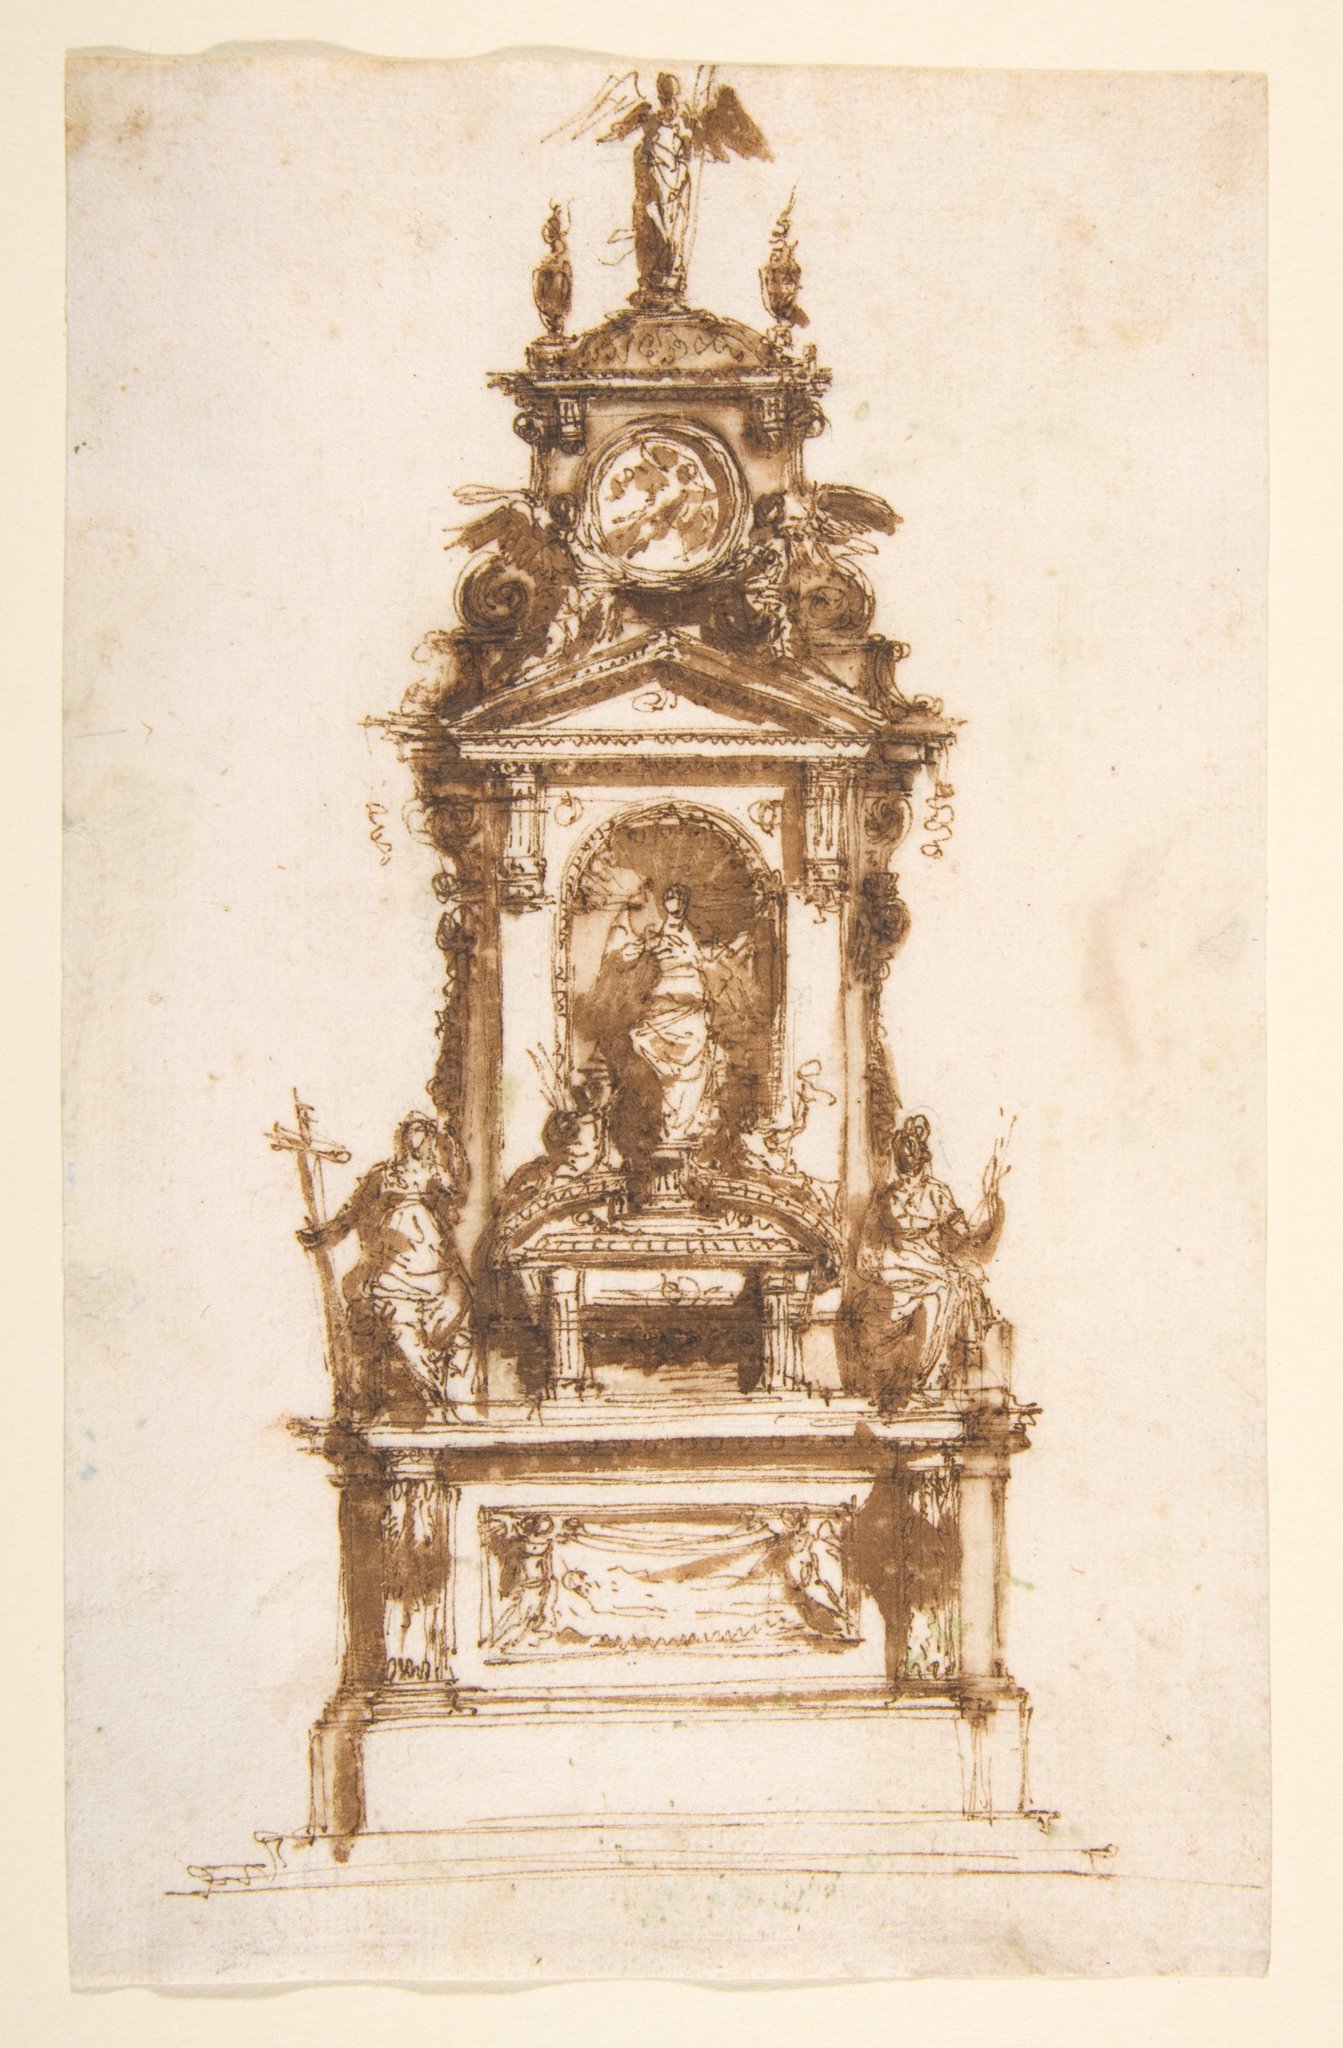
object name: drawing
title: Design for an Altar Erected for the Holy Week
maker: mauro antonio tesi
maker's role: artist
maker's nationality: italian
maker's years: 1730-1766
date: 1750-1766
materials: ink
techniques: brush, pen, wash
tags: altars,angels,cross,jesus